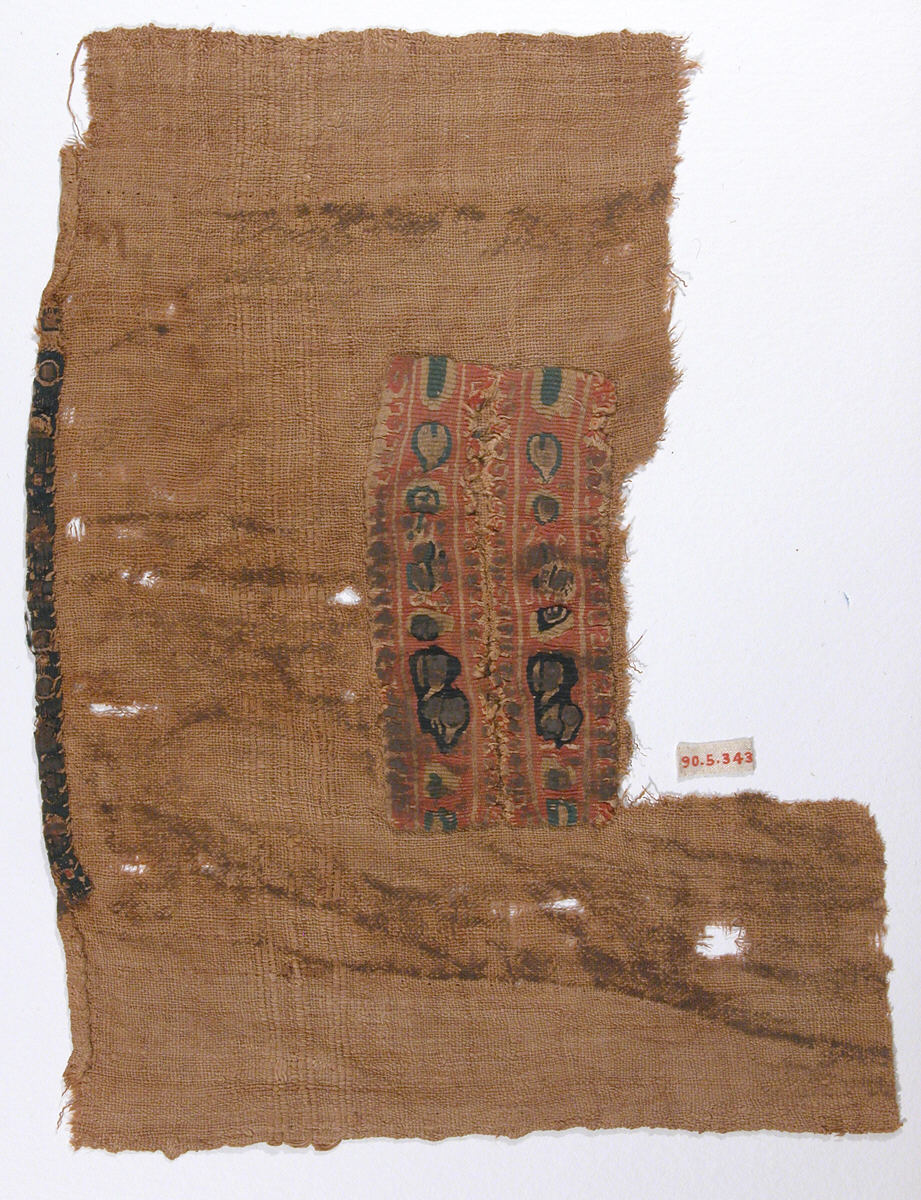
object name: tunic fragment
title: Fragment of a Tunic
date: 401-600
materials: linen, wool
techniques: weave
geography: egypt